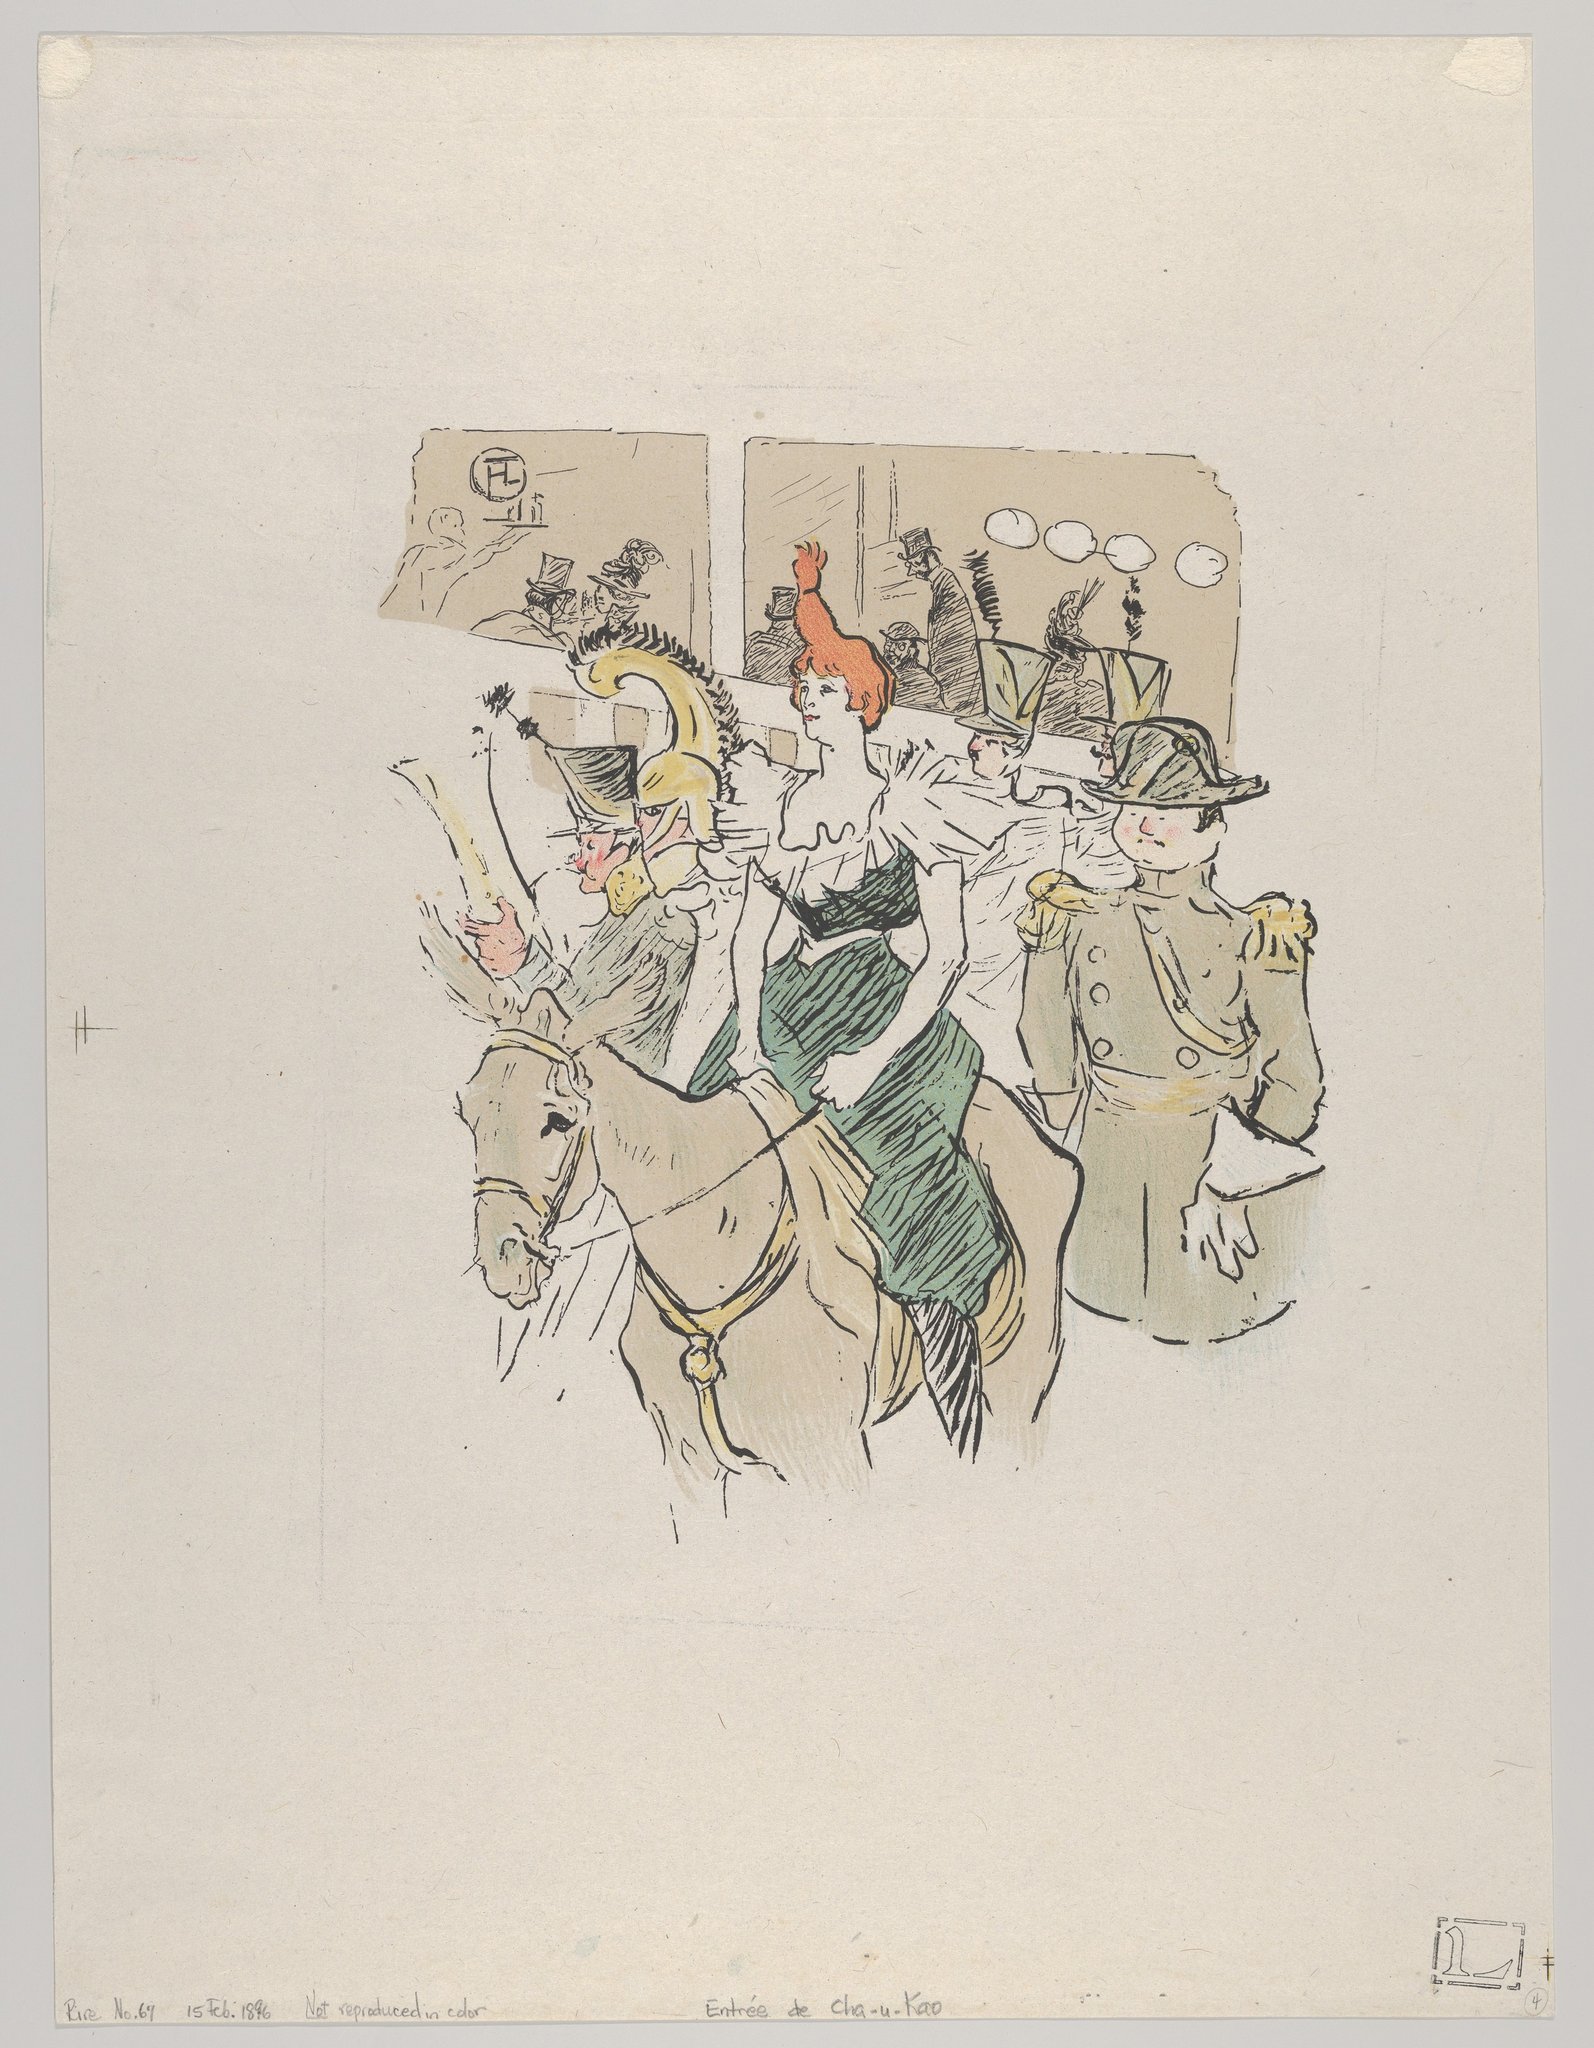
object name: print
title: Entrée de Cha-u-Kao, from Le Rire, No. 67, 15 February 1896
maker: henri de toulouse-lautrec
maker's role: artist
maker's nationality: french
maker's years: 1864-1901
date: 1896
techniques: lithograph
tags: men,women,horses,dancers